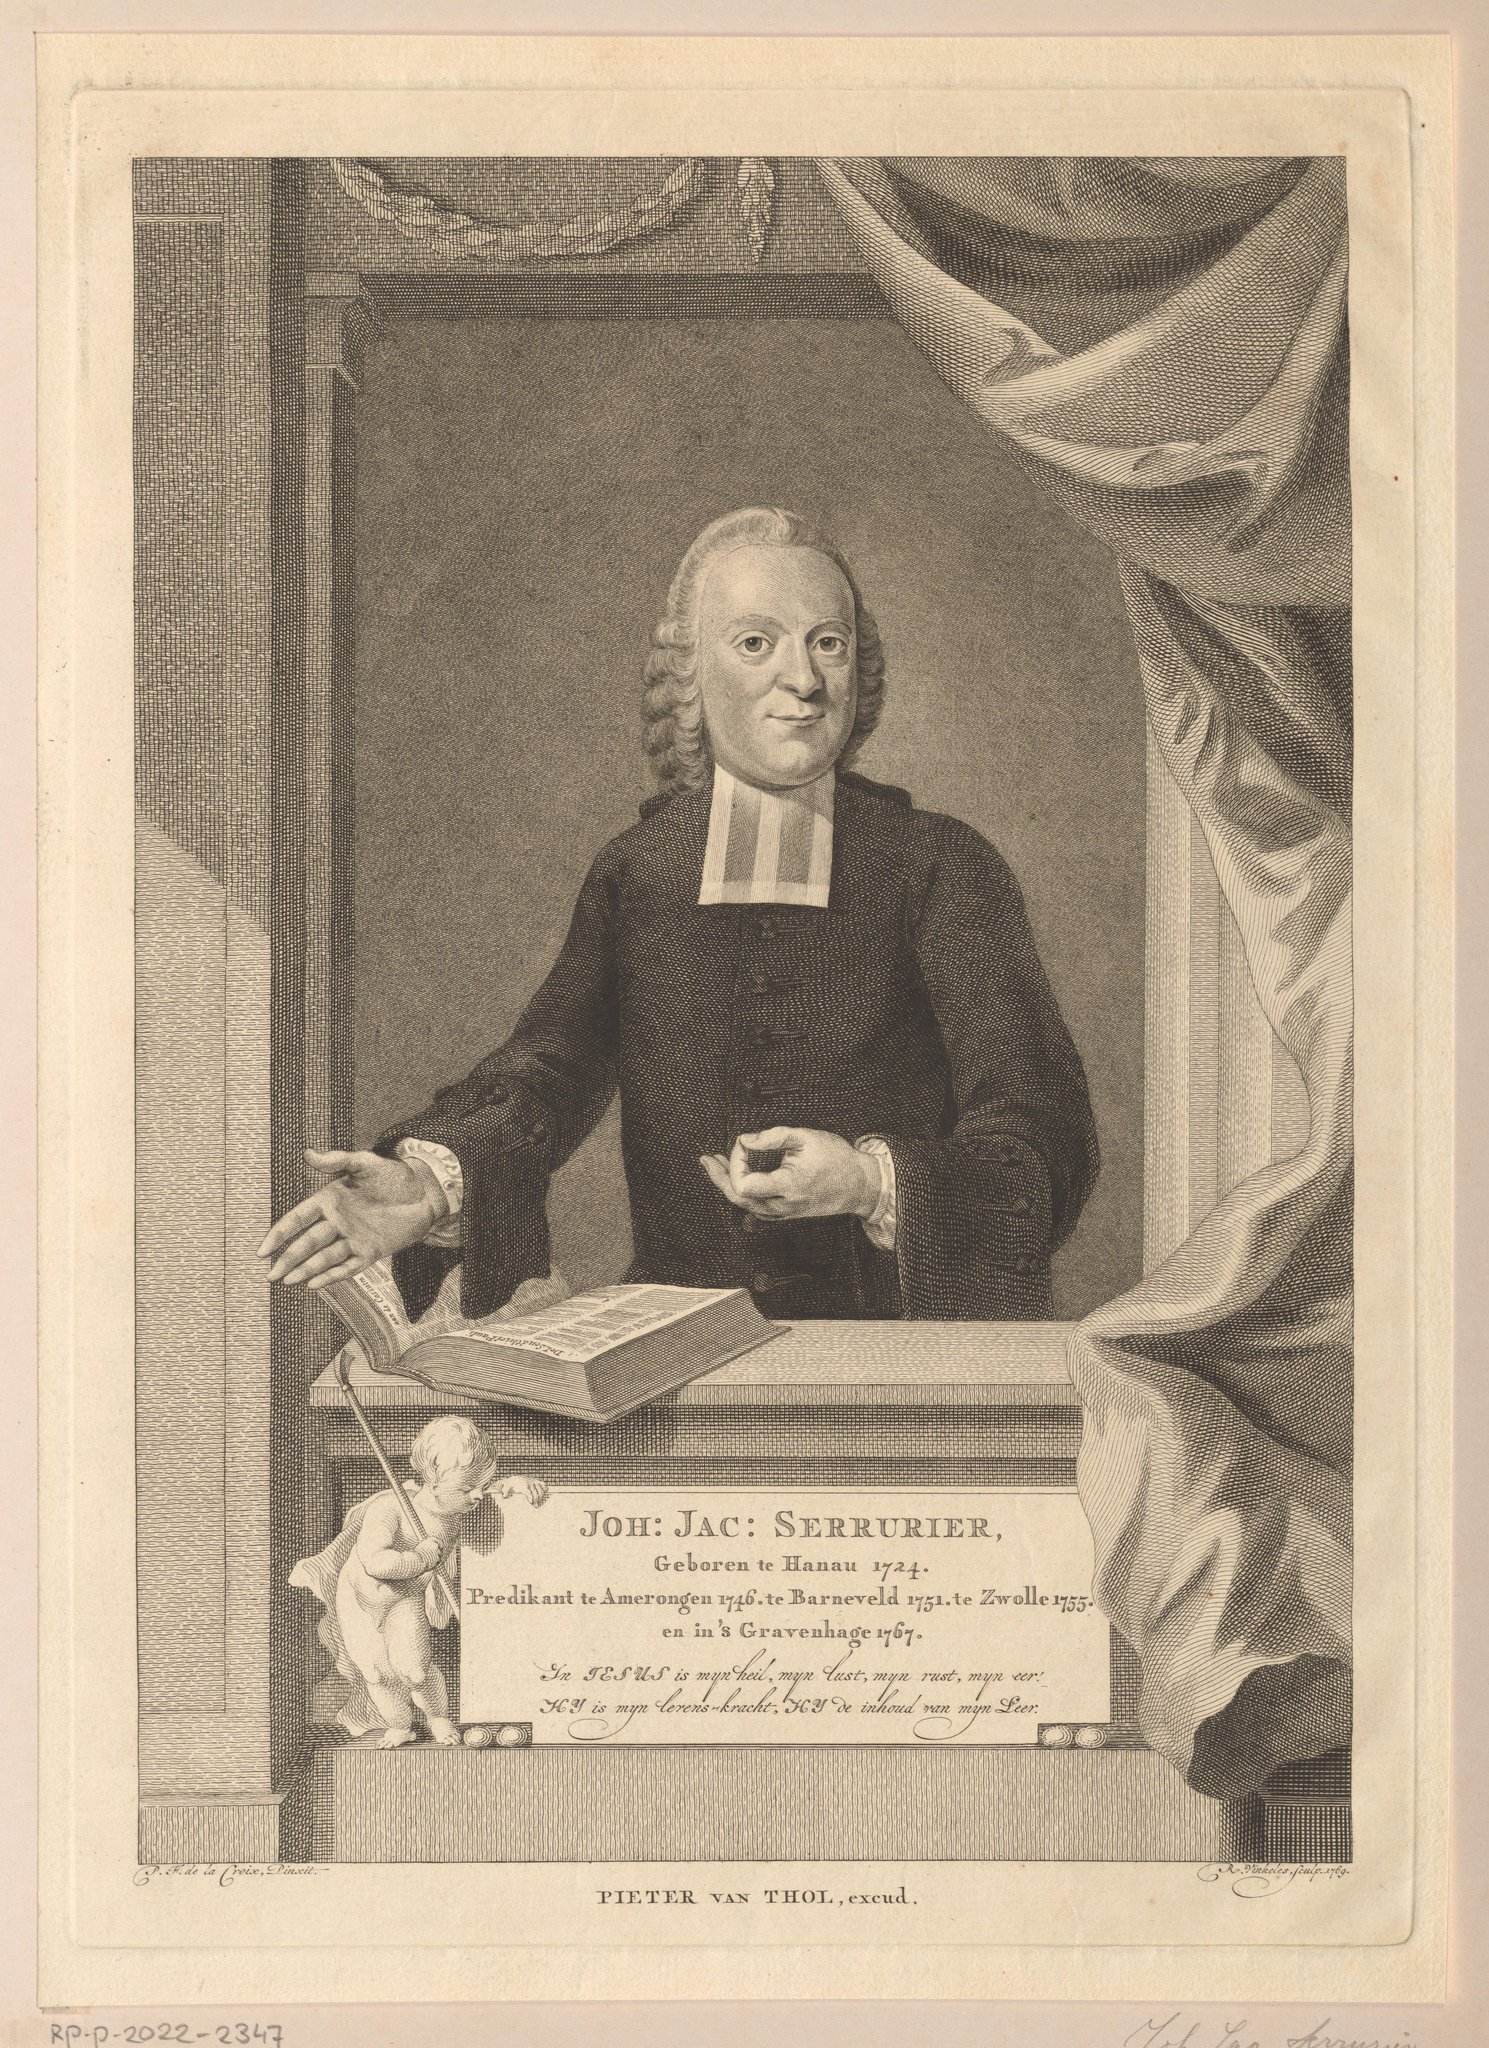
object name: print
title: Portret van Johannes Jacobus Serrurier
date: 1769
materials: paper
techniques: engraving, etching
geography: amsterdam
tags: historical persons, organization, functionaries and dignitaries in churches and in related institutions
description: Met vijfregelig onderschrift in het Nederlands.